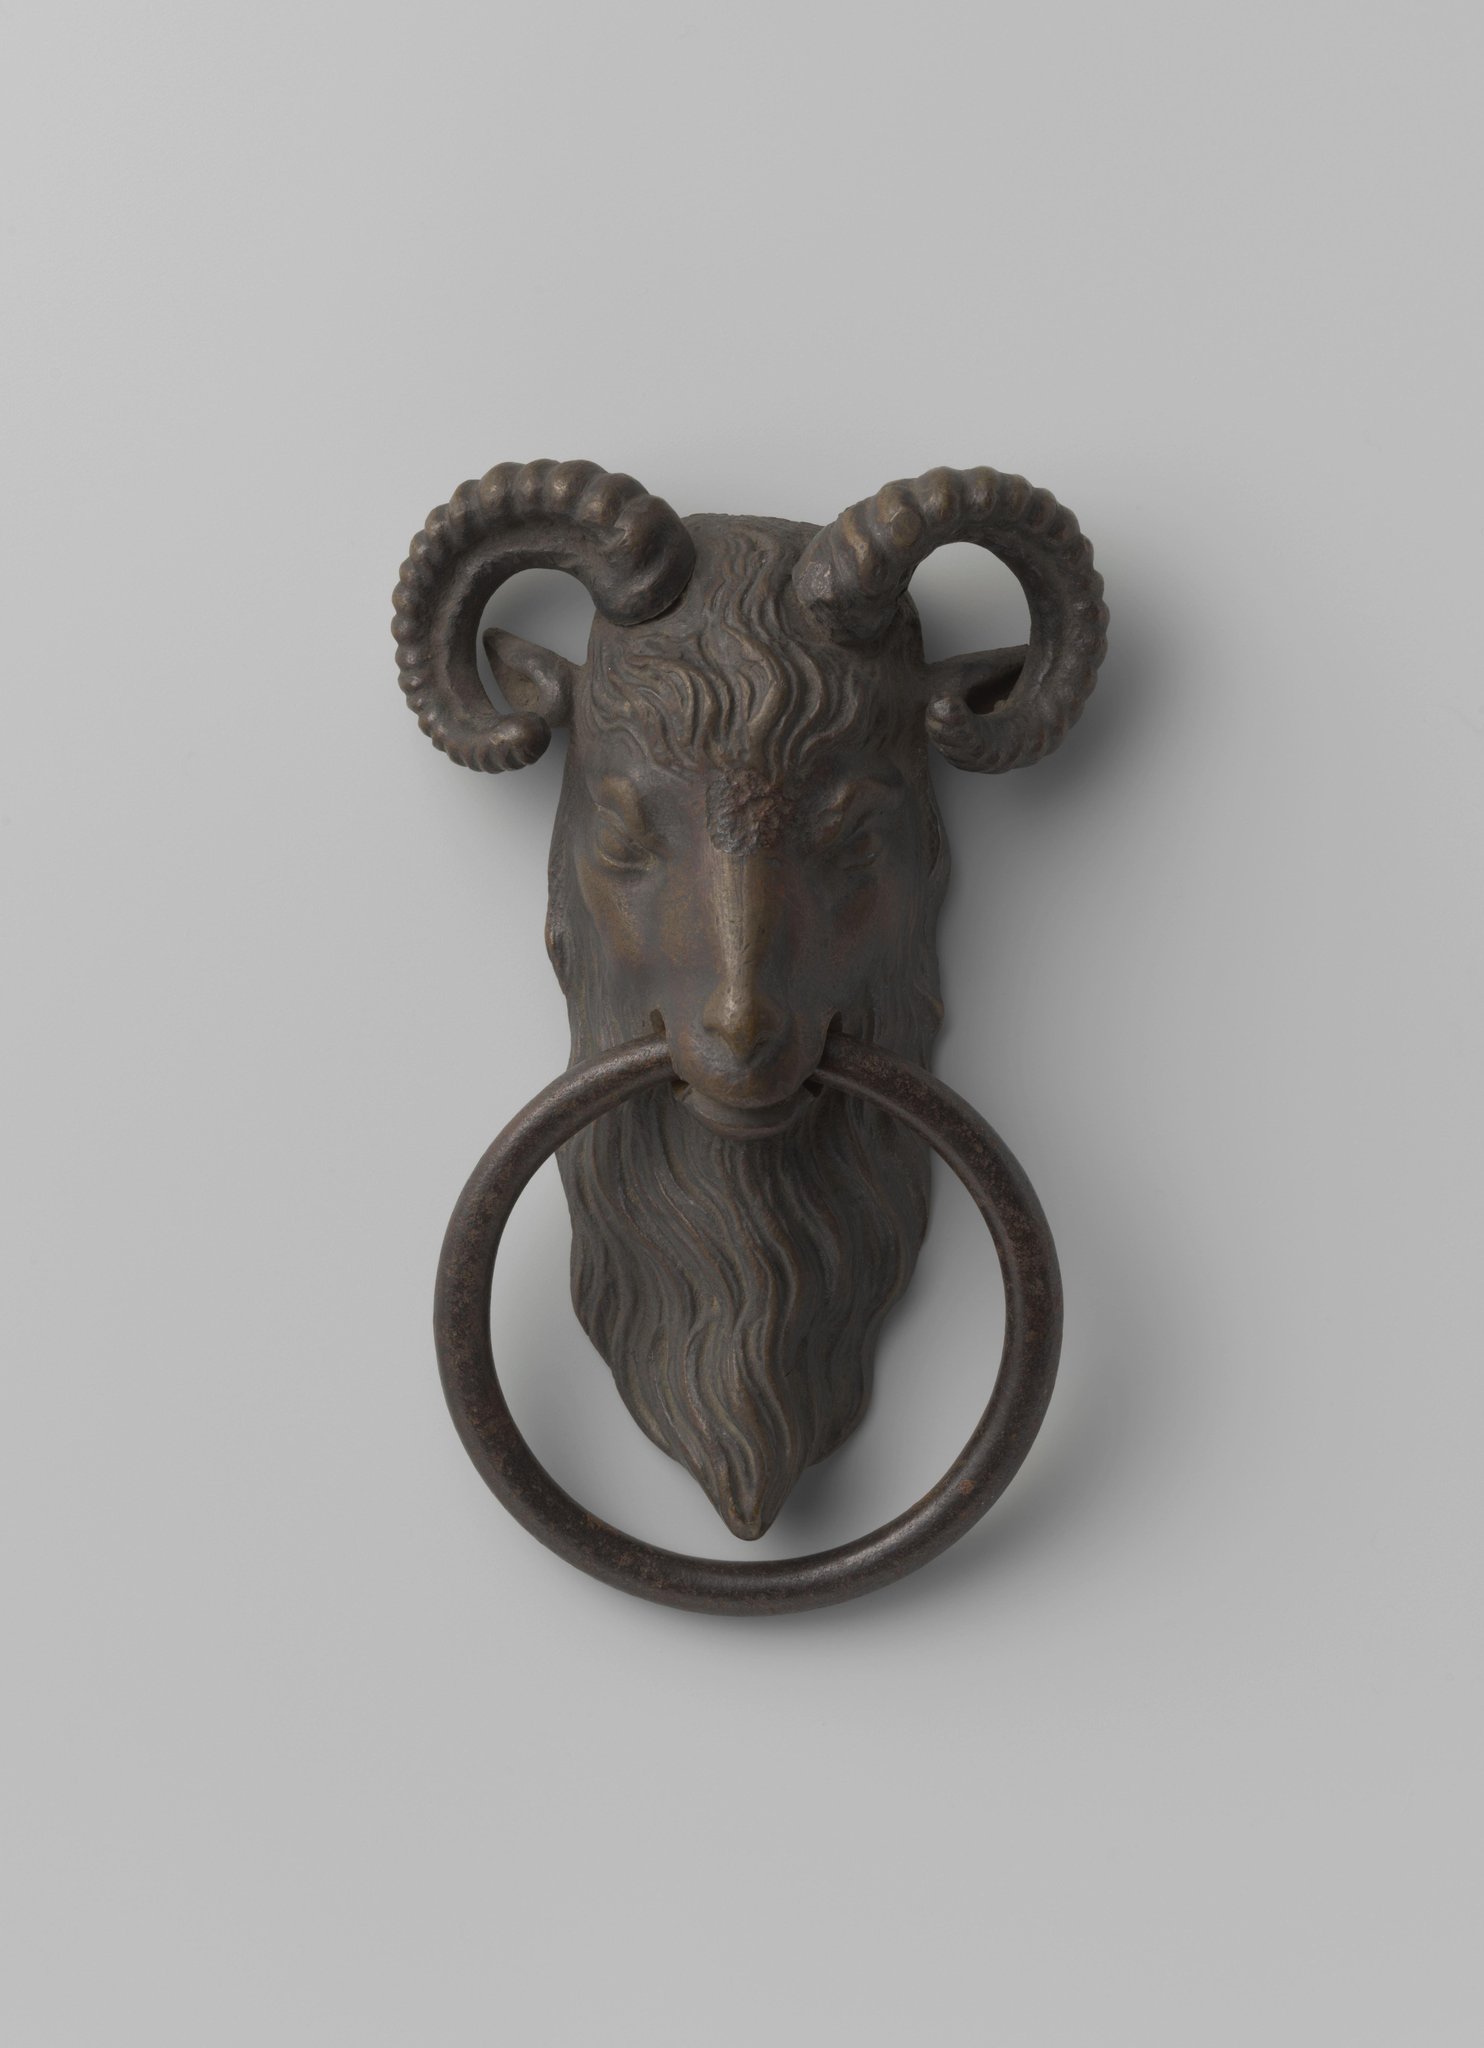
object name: figure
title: Bokkenkop met een ring door de bek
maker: Anonymous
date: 1700-1800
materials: brass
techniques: casting, metalworking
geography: western europe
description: Het gegoten en bijgeciseleerde voorwerp bestaat uit vier delen: de kop, de hoorns en de ring.